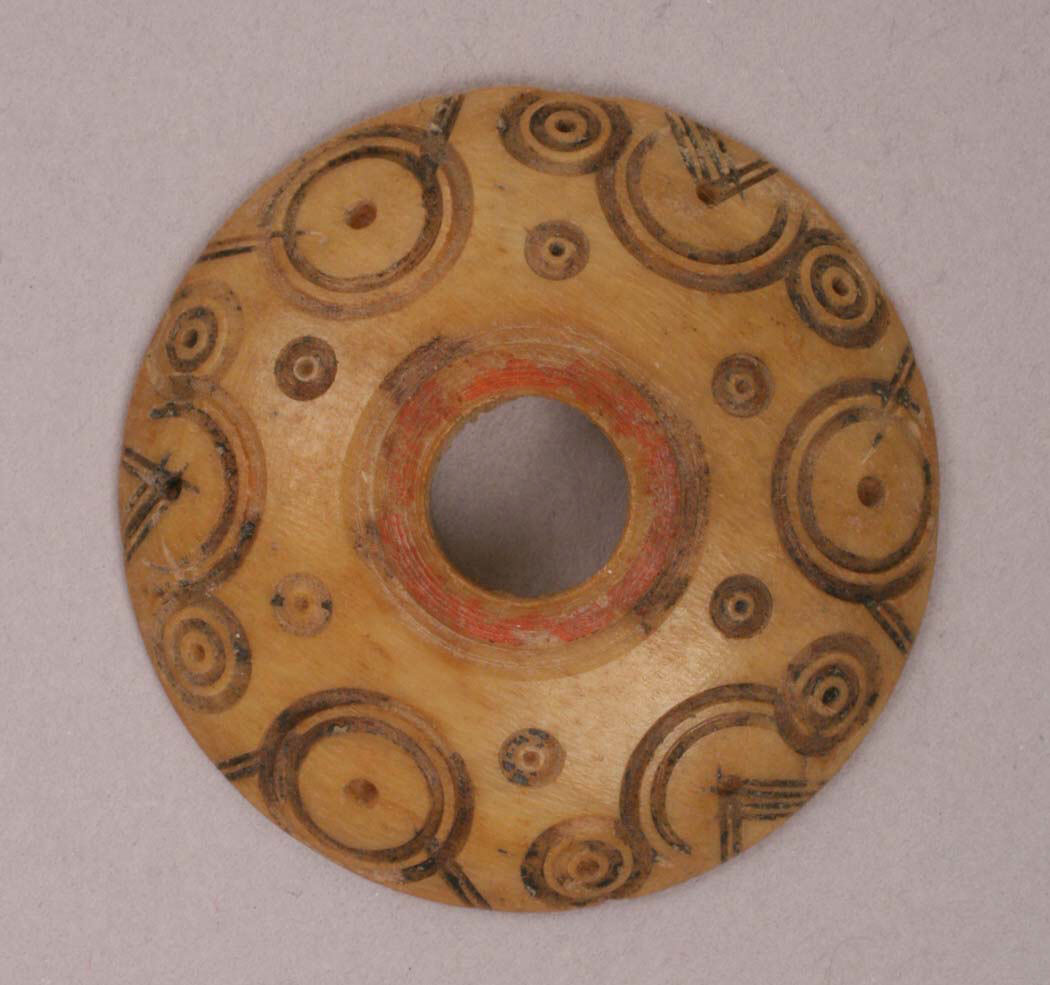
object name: button or spindle whorl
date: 801-1000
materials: bone, paint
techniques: incising, inlay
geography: iran